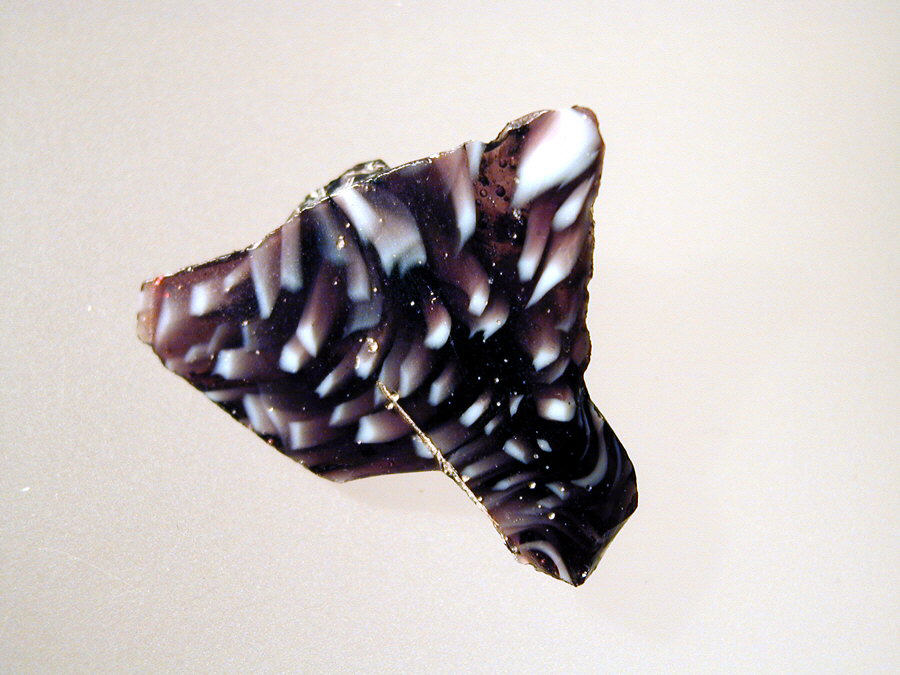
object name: fragment, mosaic bowl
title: Glass mosaic ribbed bowl fragment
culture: roman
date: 34 BCE-33 CE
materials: glass